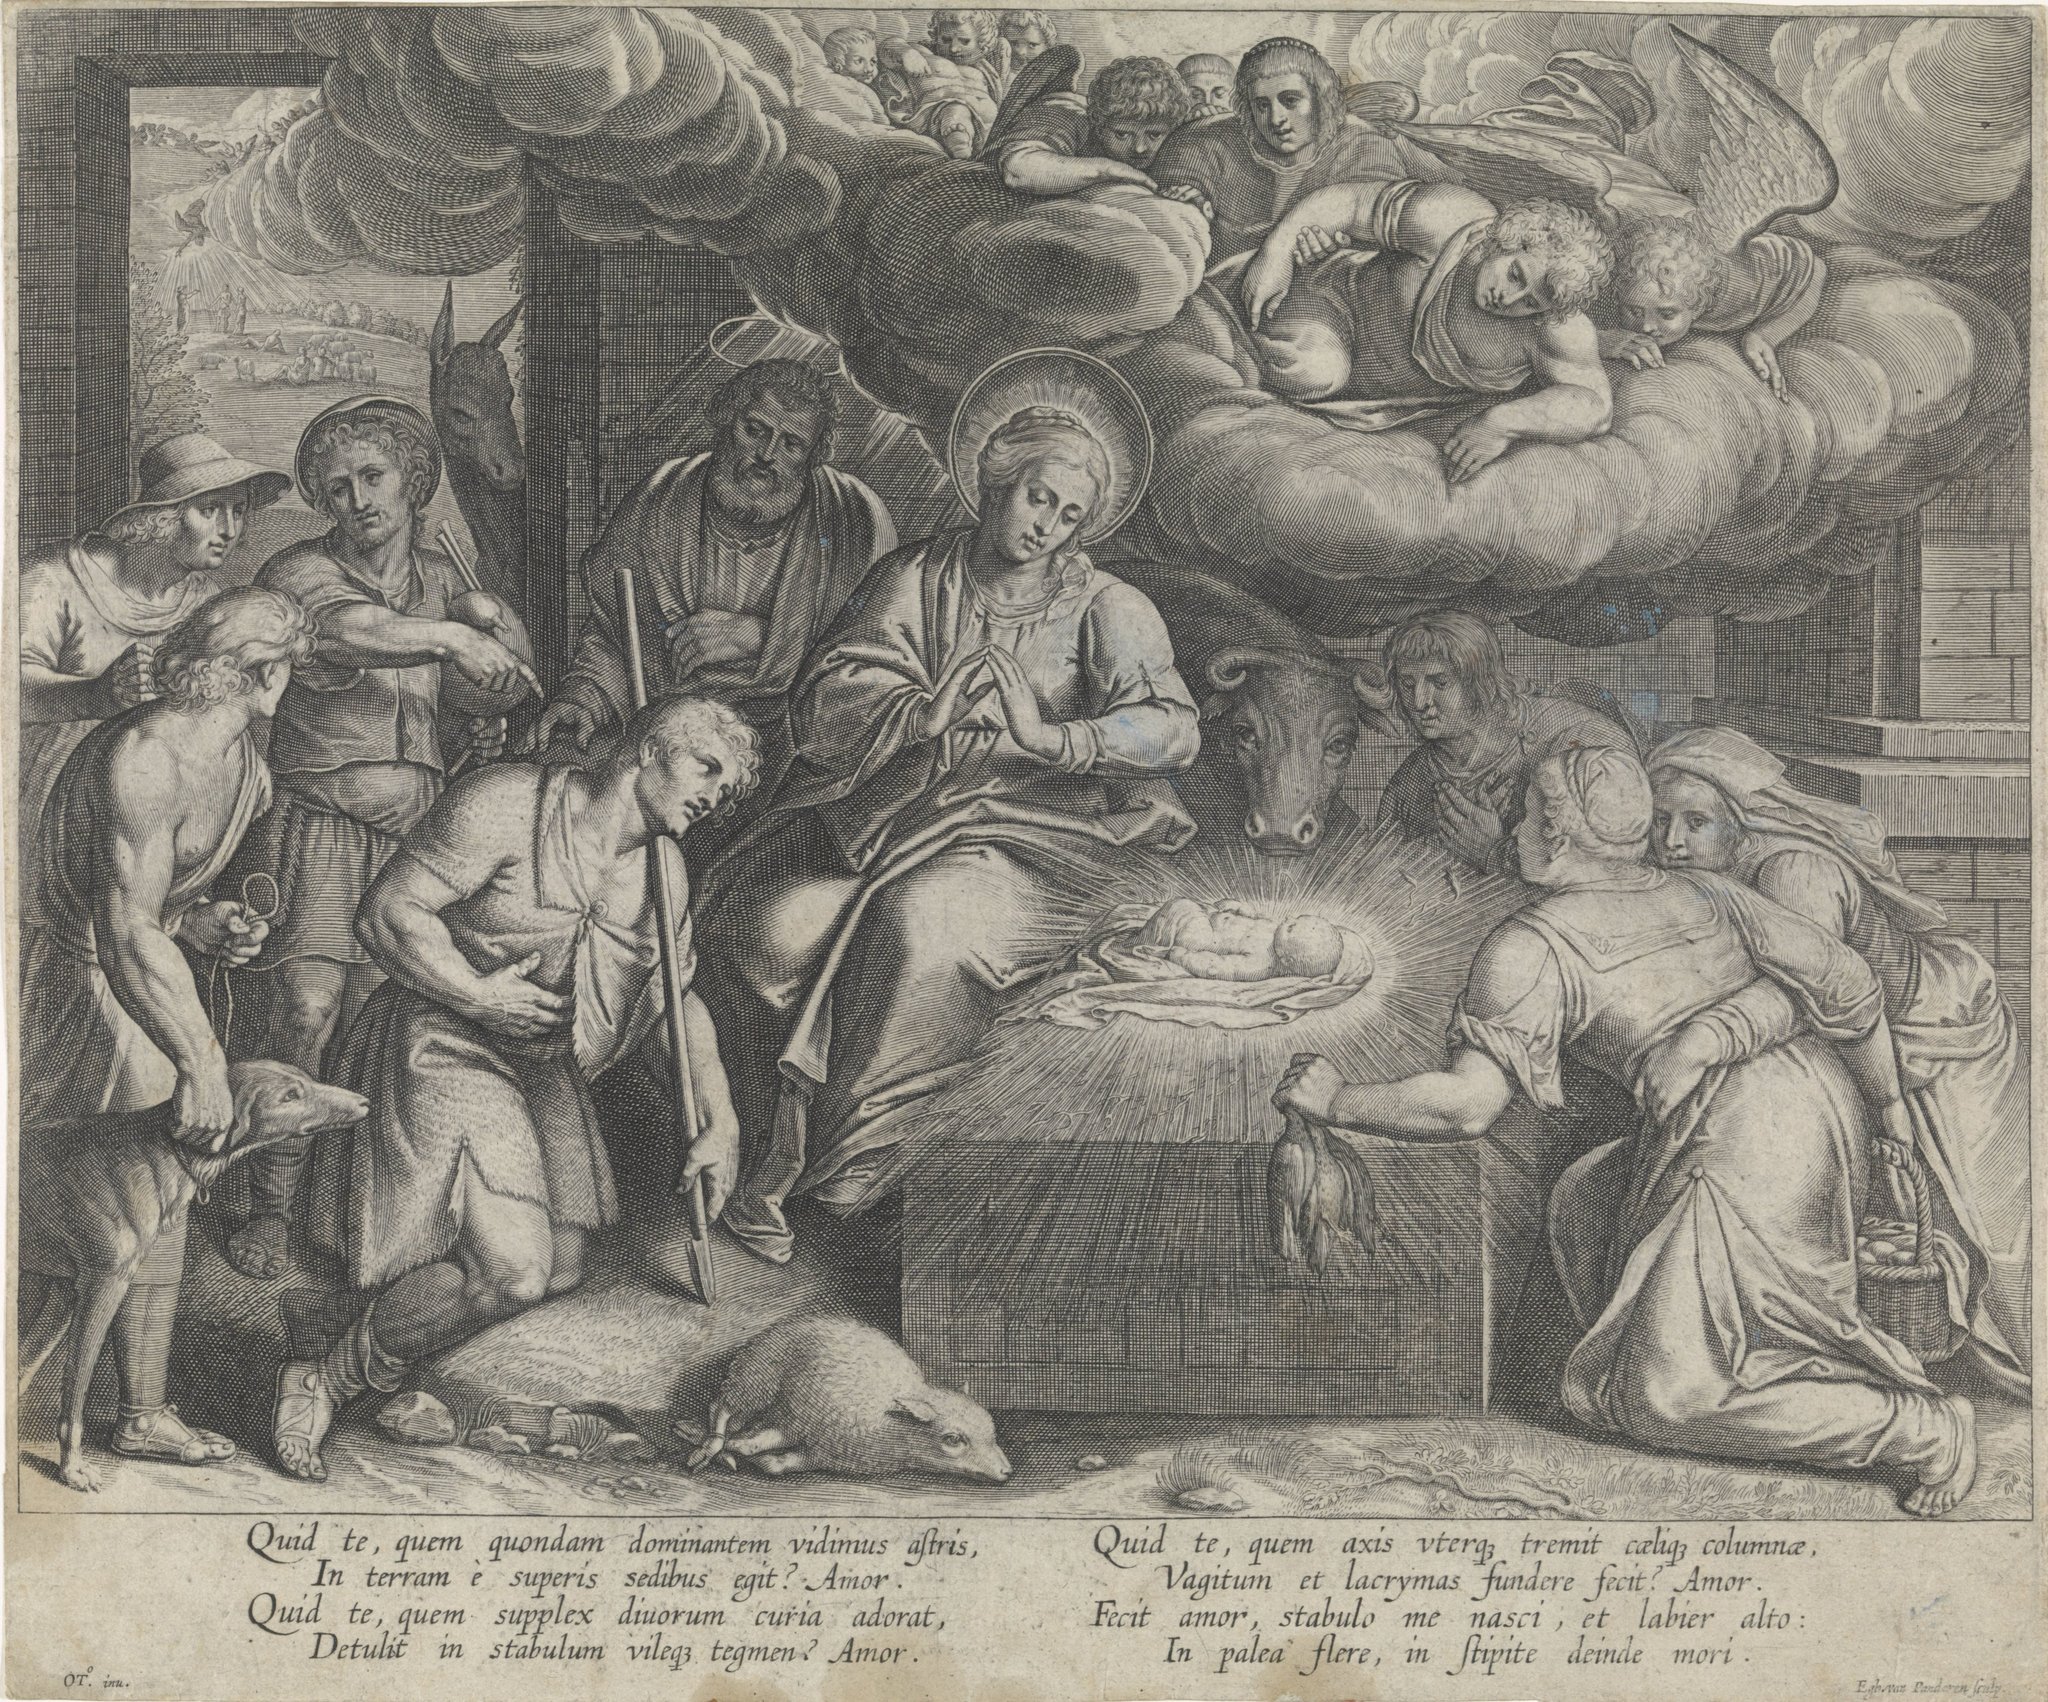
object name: print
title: Aanbidding door de herders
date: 1590-1637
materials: paper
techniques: engraving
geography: antwerp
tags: adoration of the christ-child by the shepherds; mary and joseph present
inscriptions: collector's mark: Lugt 2228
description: Maria zit naast het Christuskind, achter haar staat Jozef. De herders scharen zich in aanbidding om hen heen. Engelen kijken toe vanuit de hemel. Op de achtergrond de verkondiging aan de herders. In de marge een achtregelig onderschrift, in twee kolommen, in het Latijn.